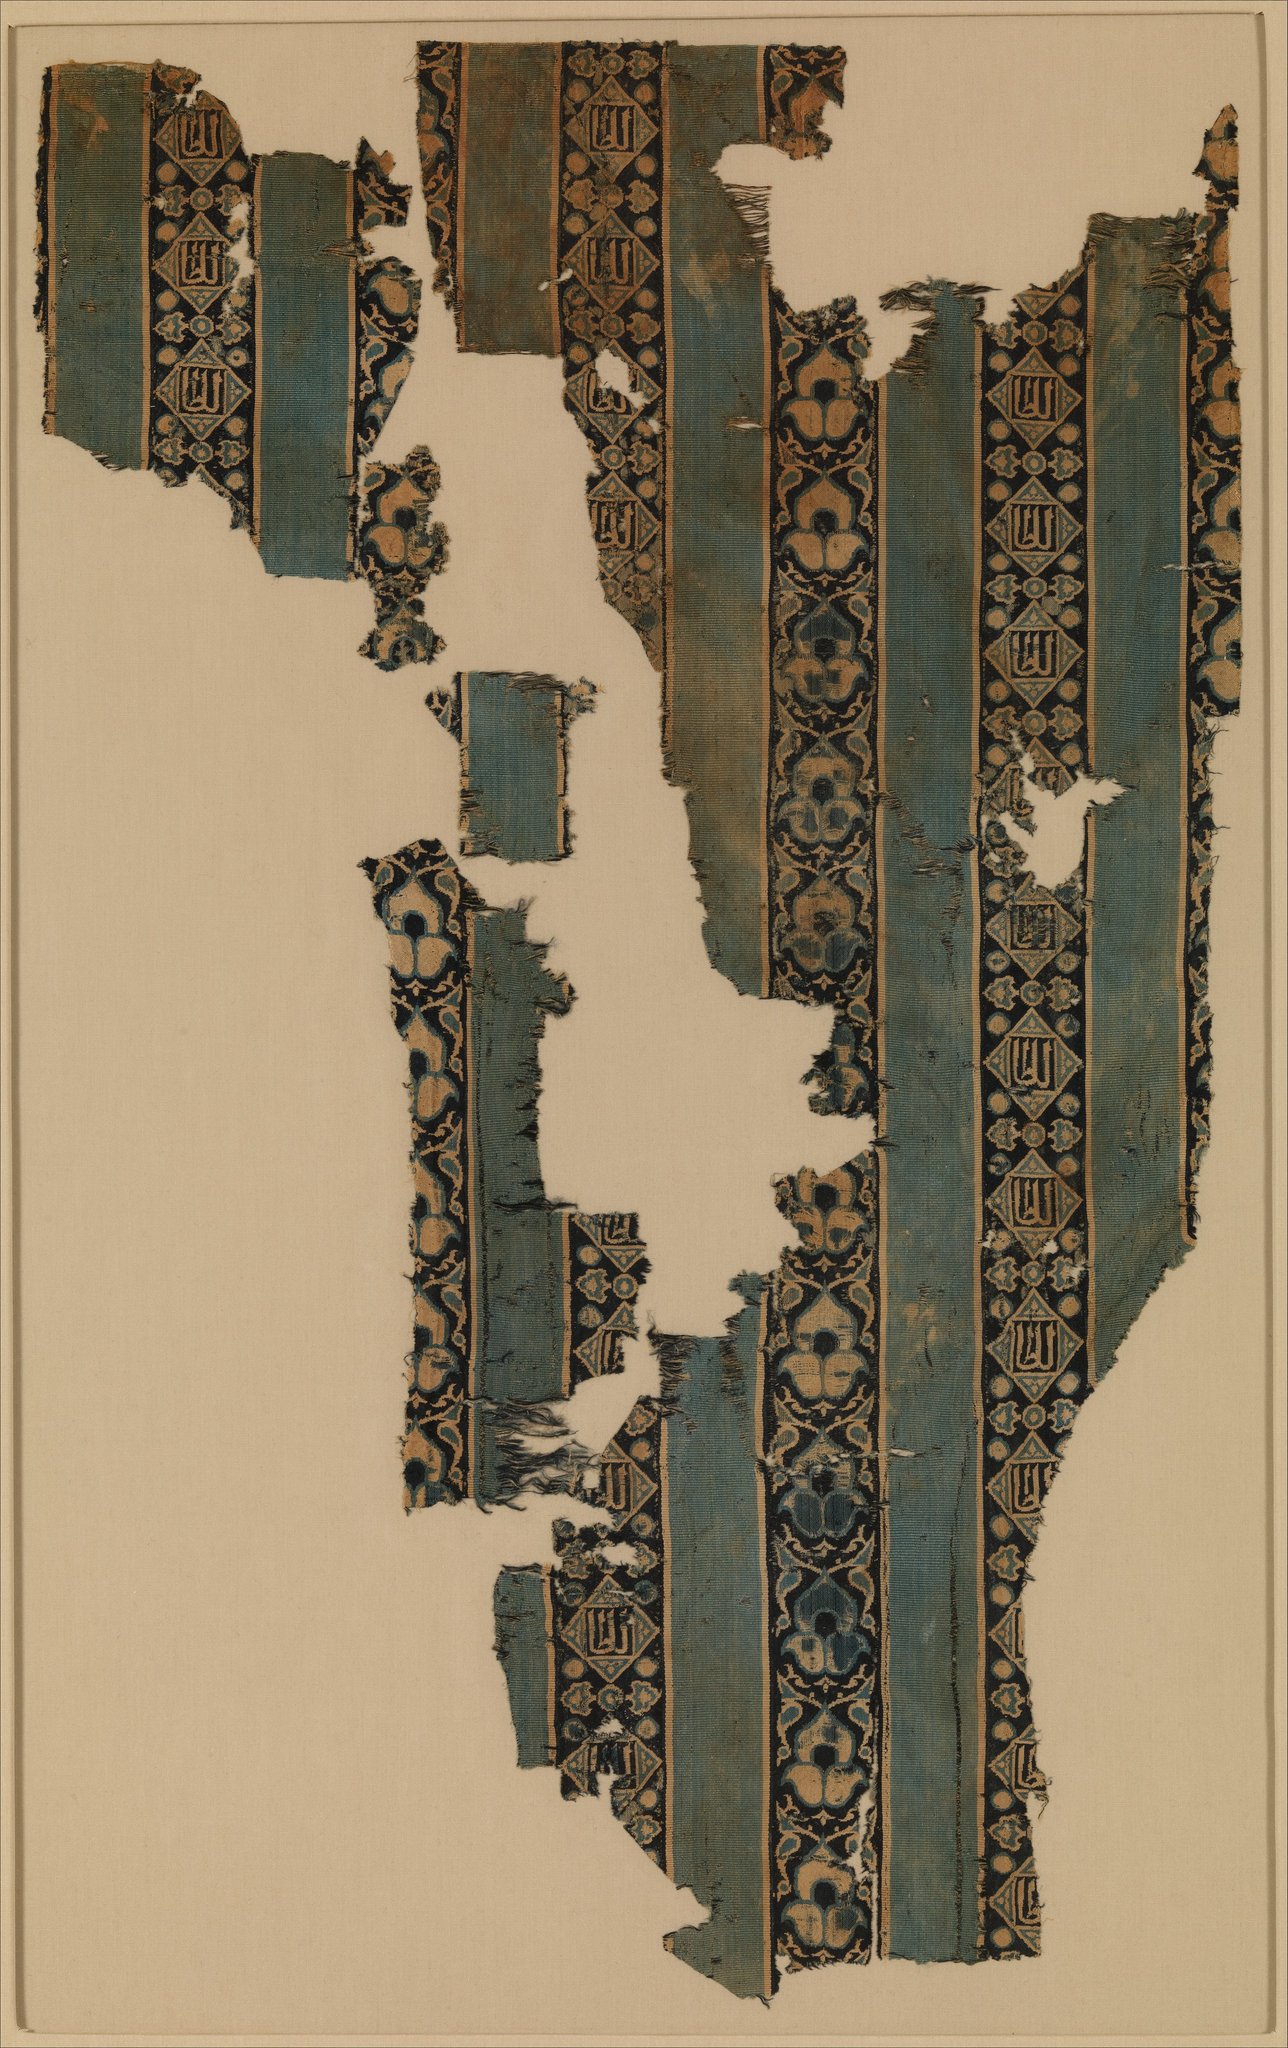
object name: textile fragment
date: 1301-1400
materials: silk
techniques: weave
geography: egypt